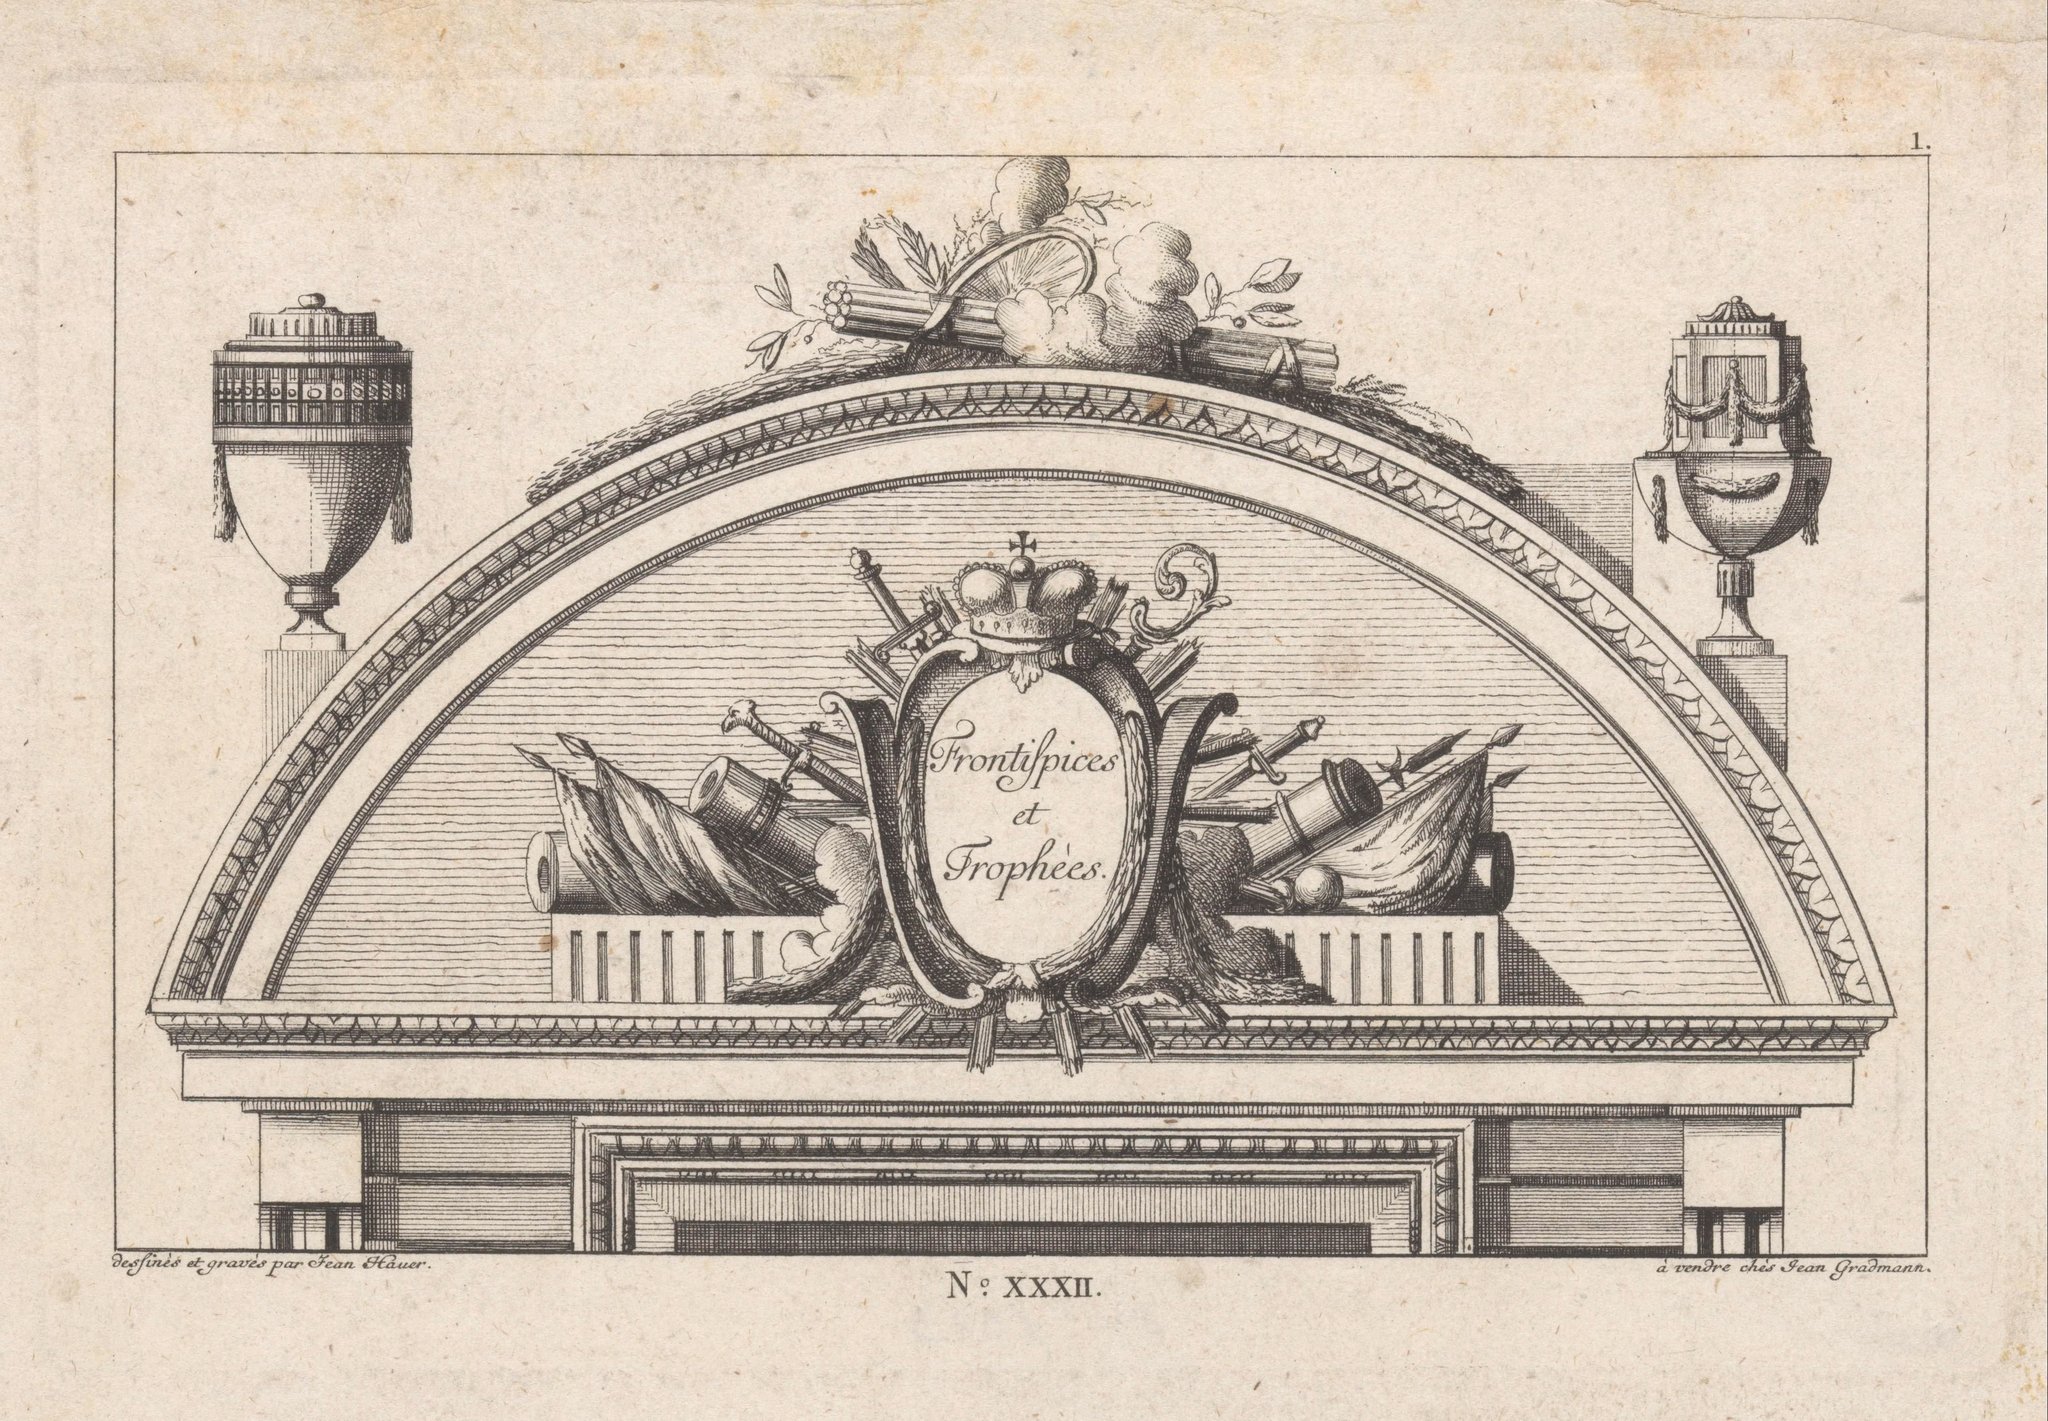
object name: print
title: Frontispices et Trophées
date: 1780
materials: paper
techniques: engraving, etching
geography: ravensburg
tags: other architectural details (with name), weapons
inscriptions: collector's mark: Lugt 2228, collector's mark: Lugt 2760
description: Ontwerp voor een halfrond fronton met bekroond cartouche met stralenkrans omgeven door kannonnen, speren, lansen en zwaarden. Links en rechts twee vazen. Uitgeversnummer XXXII.